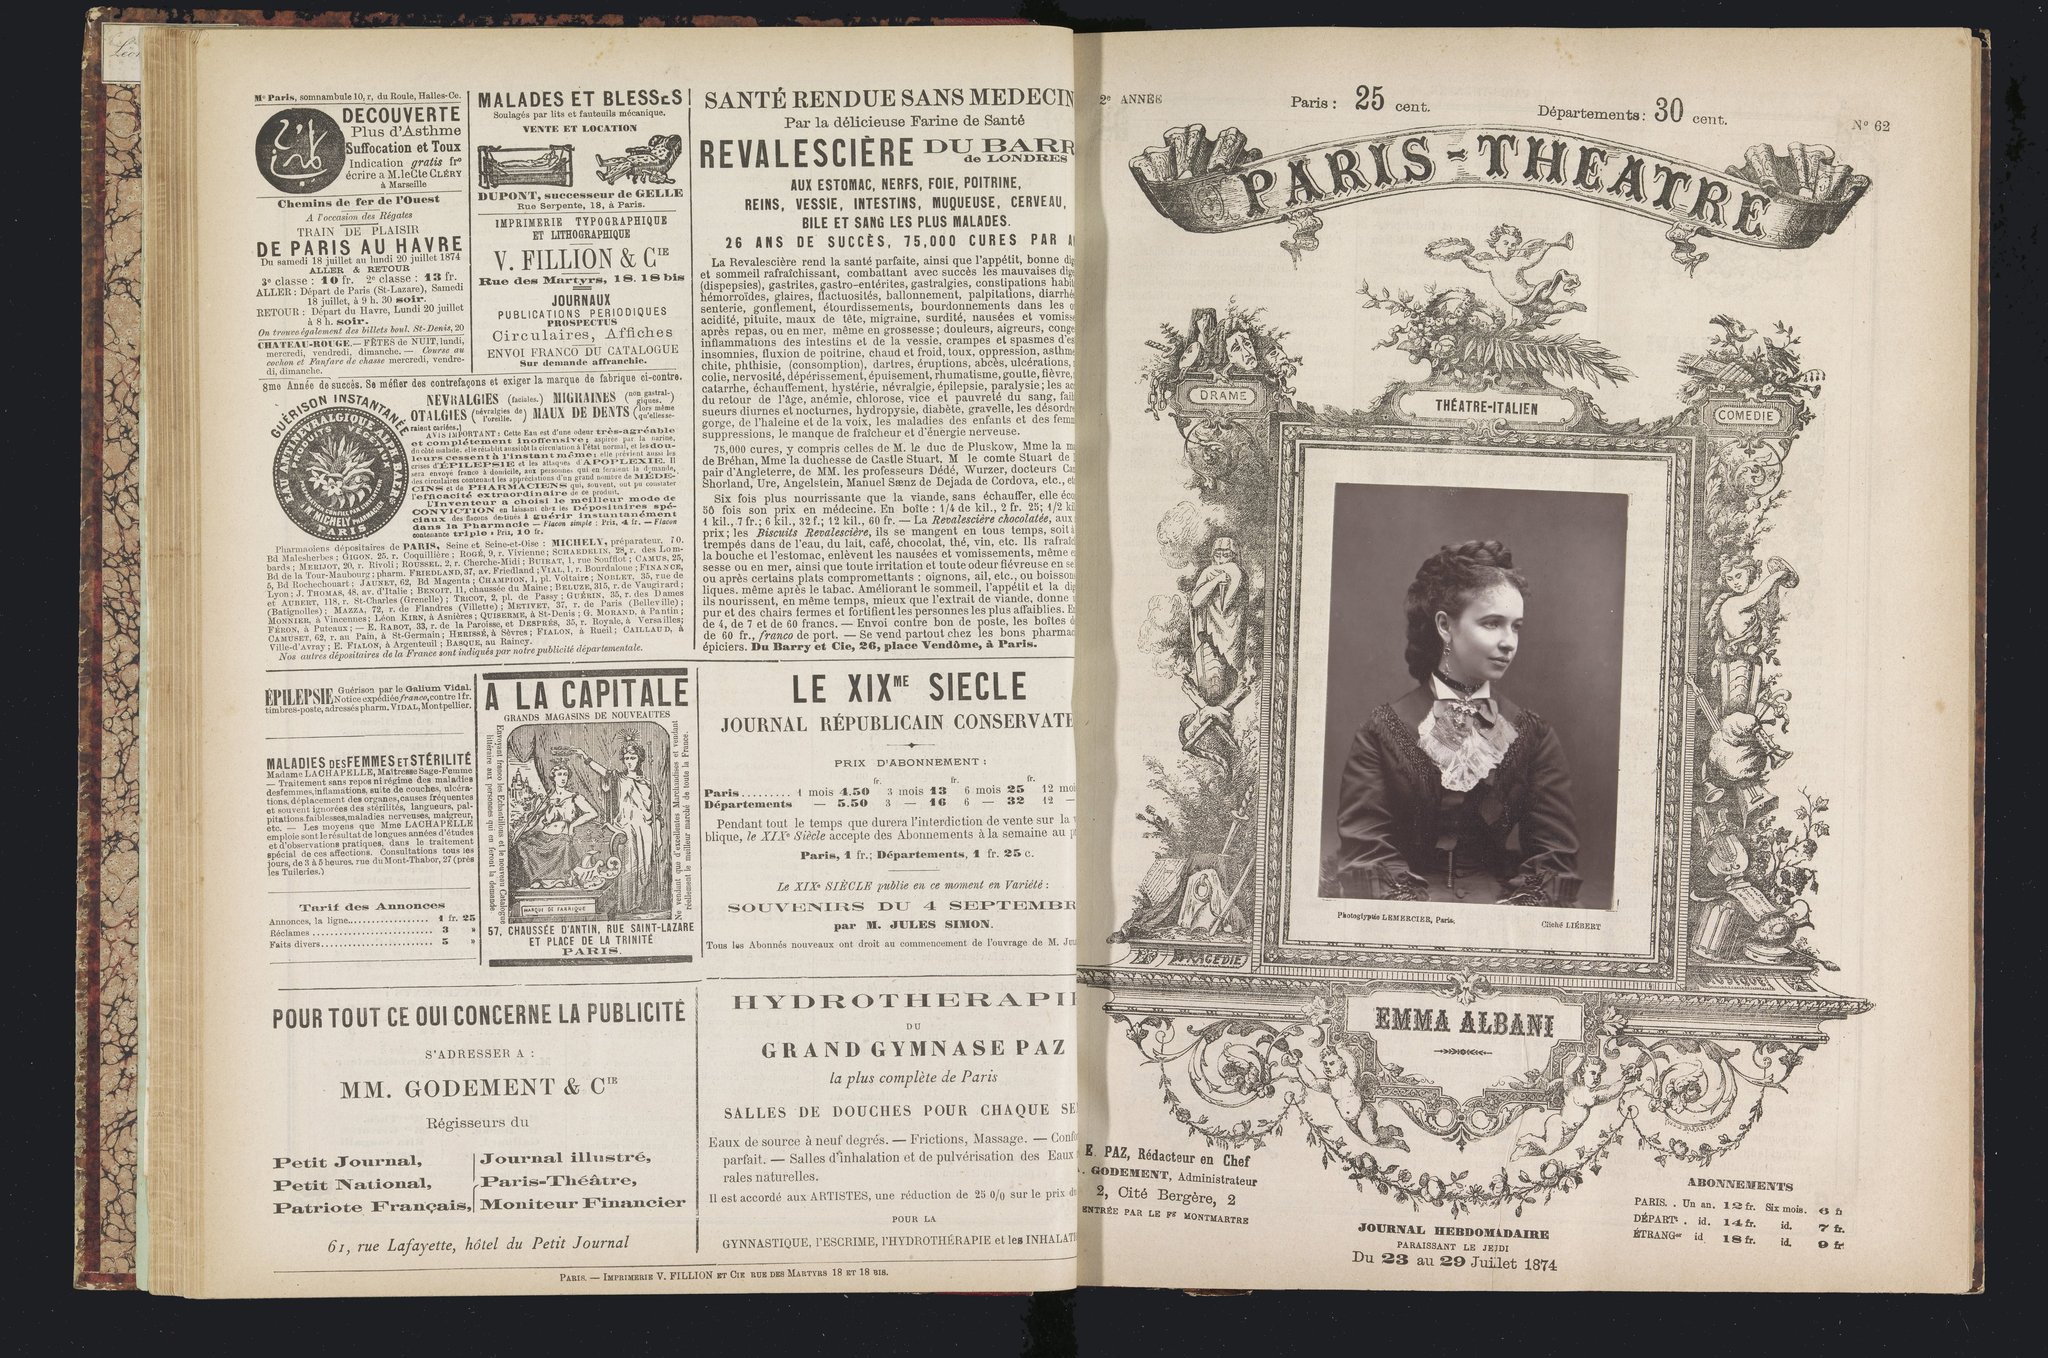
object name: page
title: Emma Albani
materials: paper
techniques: woodburytype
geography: france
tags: portrait of opera-singer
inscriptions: inscription: ‘Journal hebdomadaire paraissant le jeudi Du 23 au 29 Juillet 1874’, number: ‘No 62’